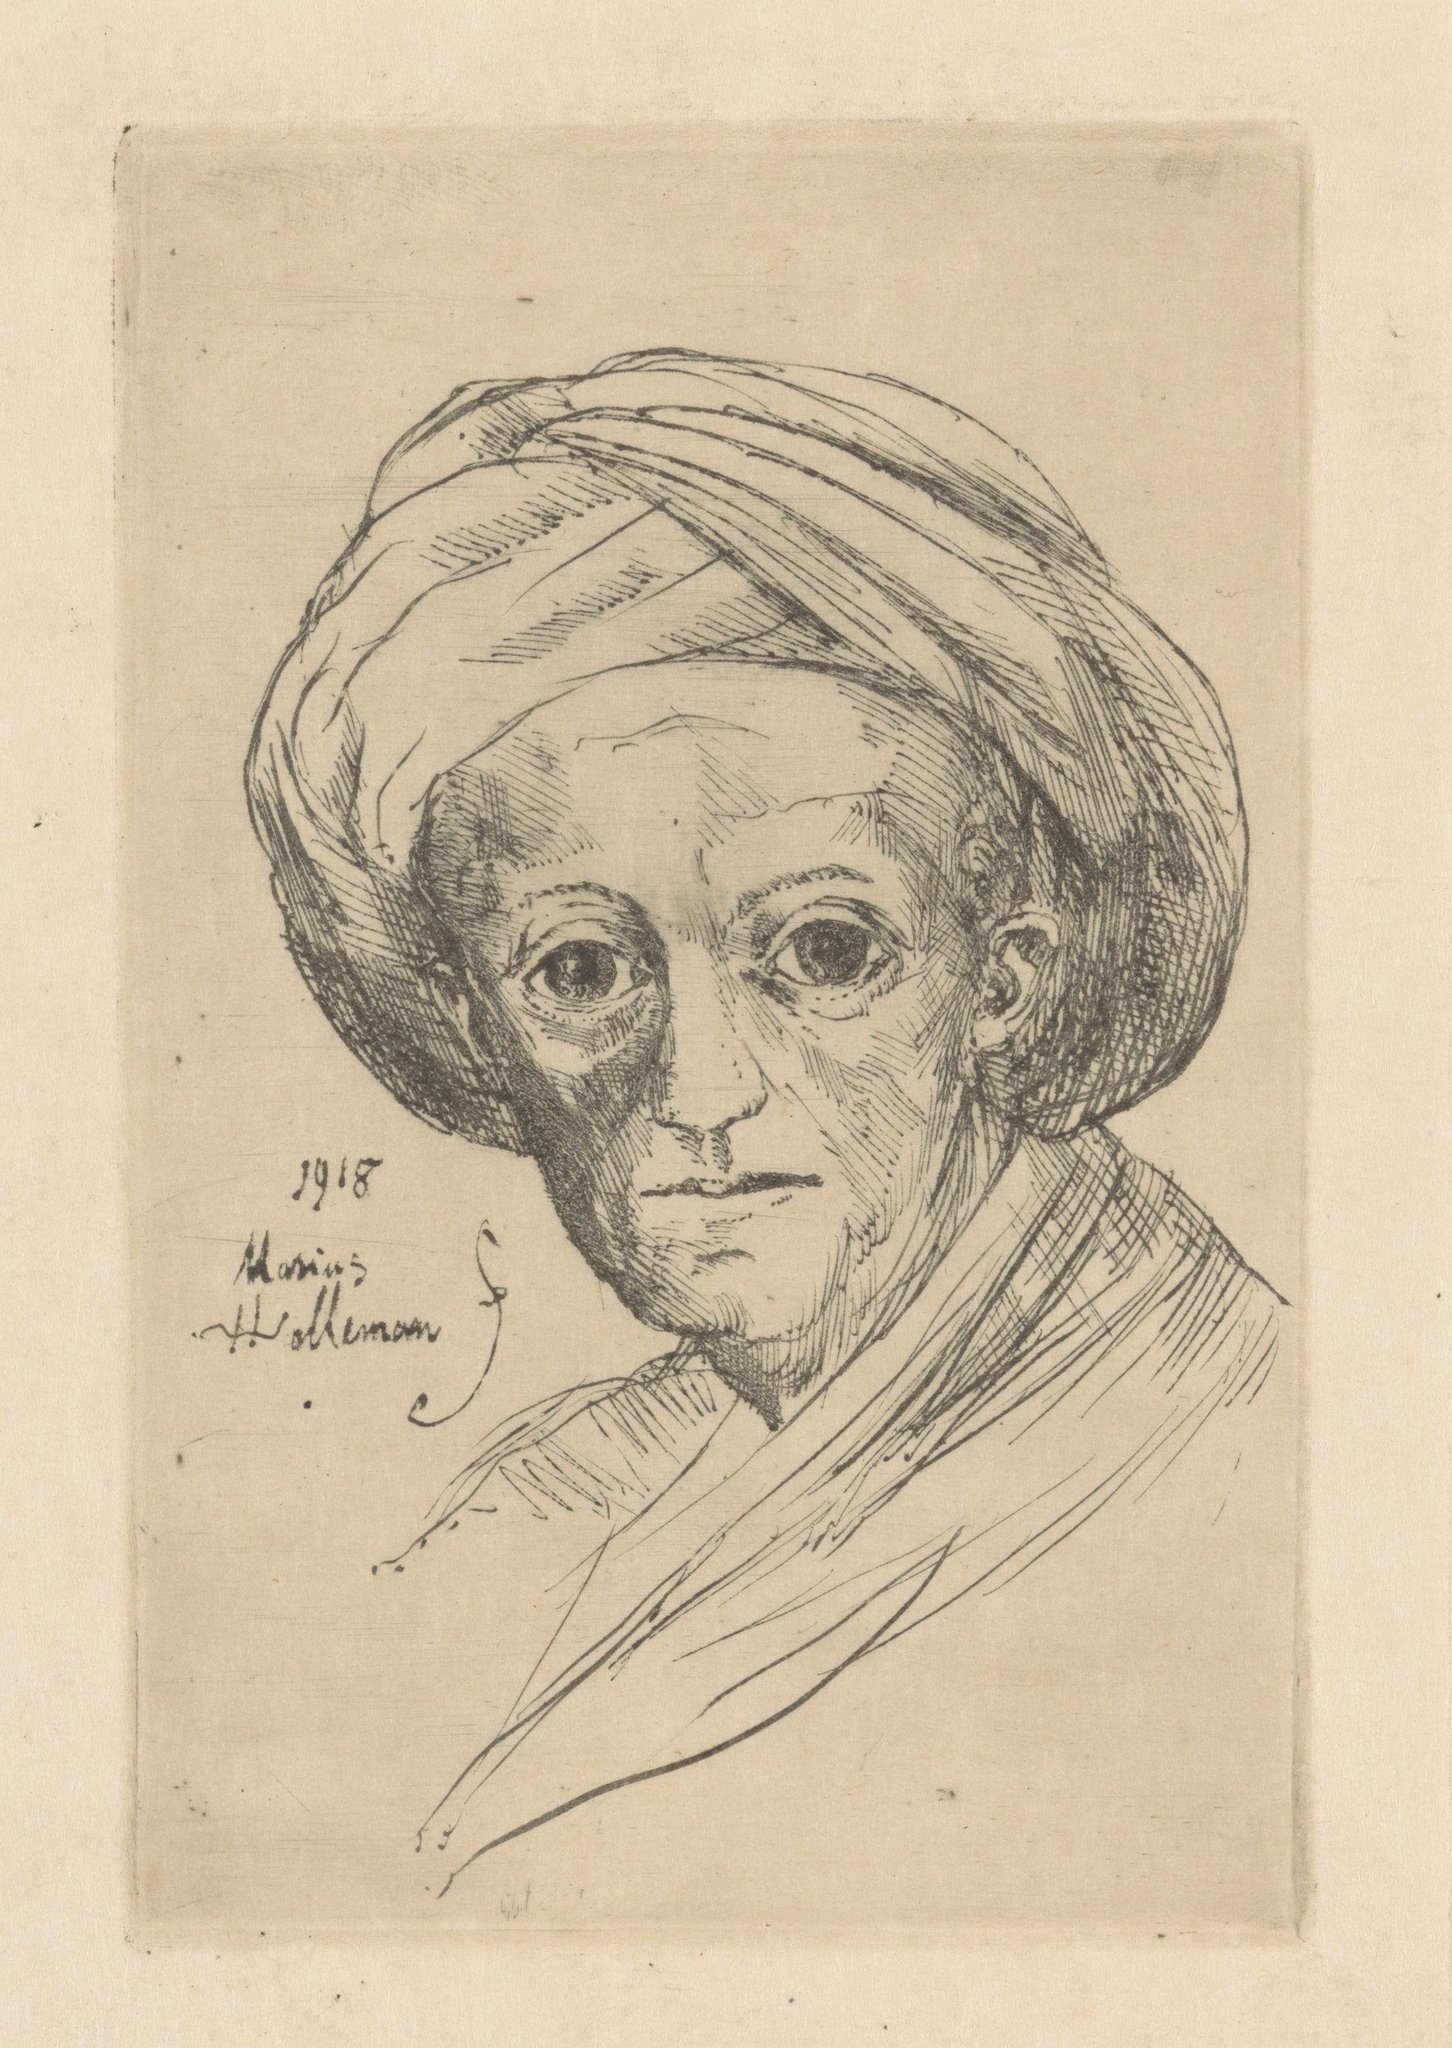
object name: print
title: Jongeman met tulband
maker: marius holleman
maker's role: draughtsman, print maker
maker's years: 1878-1926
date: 1918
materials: paper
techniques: etching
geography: groningen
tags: head-gear: turban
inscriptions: collector's mark: Lugt 2228